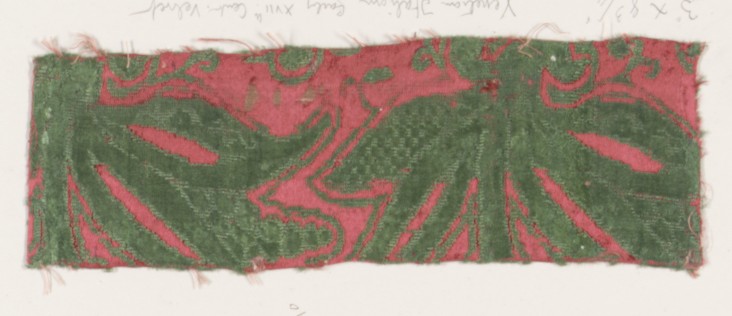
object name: fragment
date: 1601-1700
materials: silk